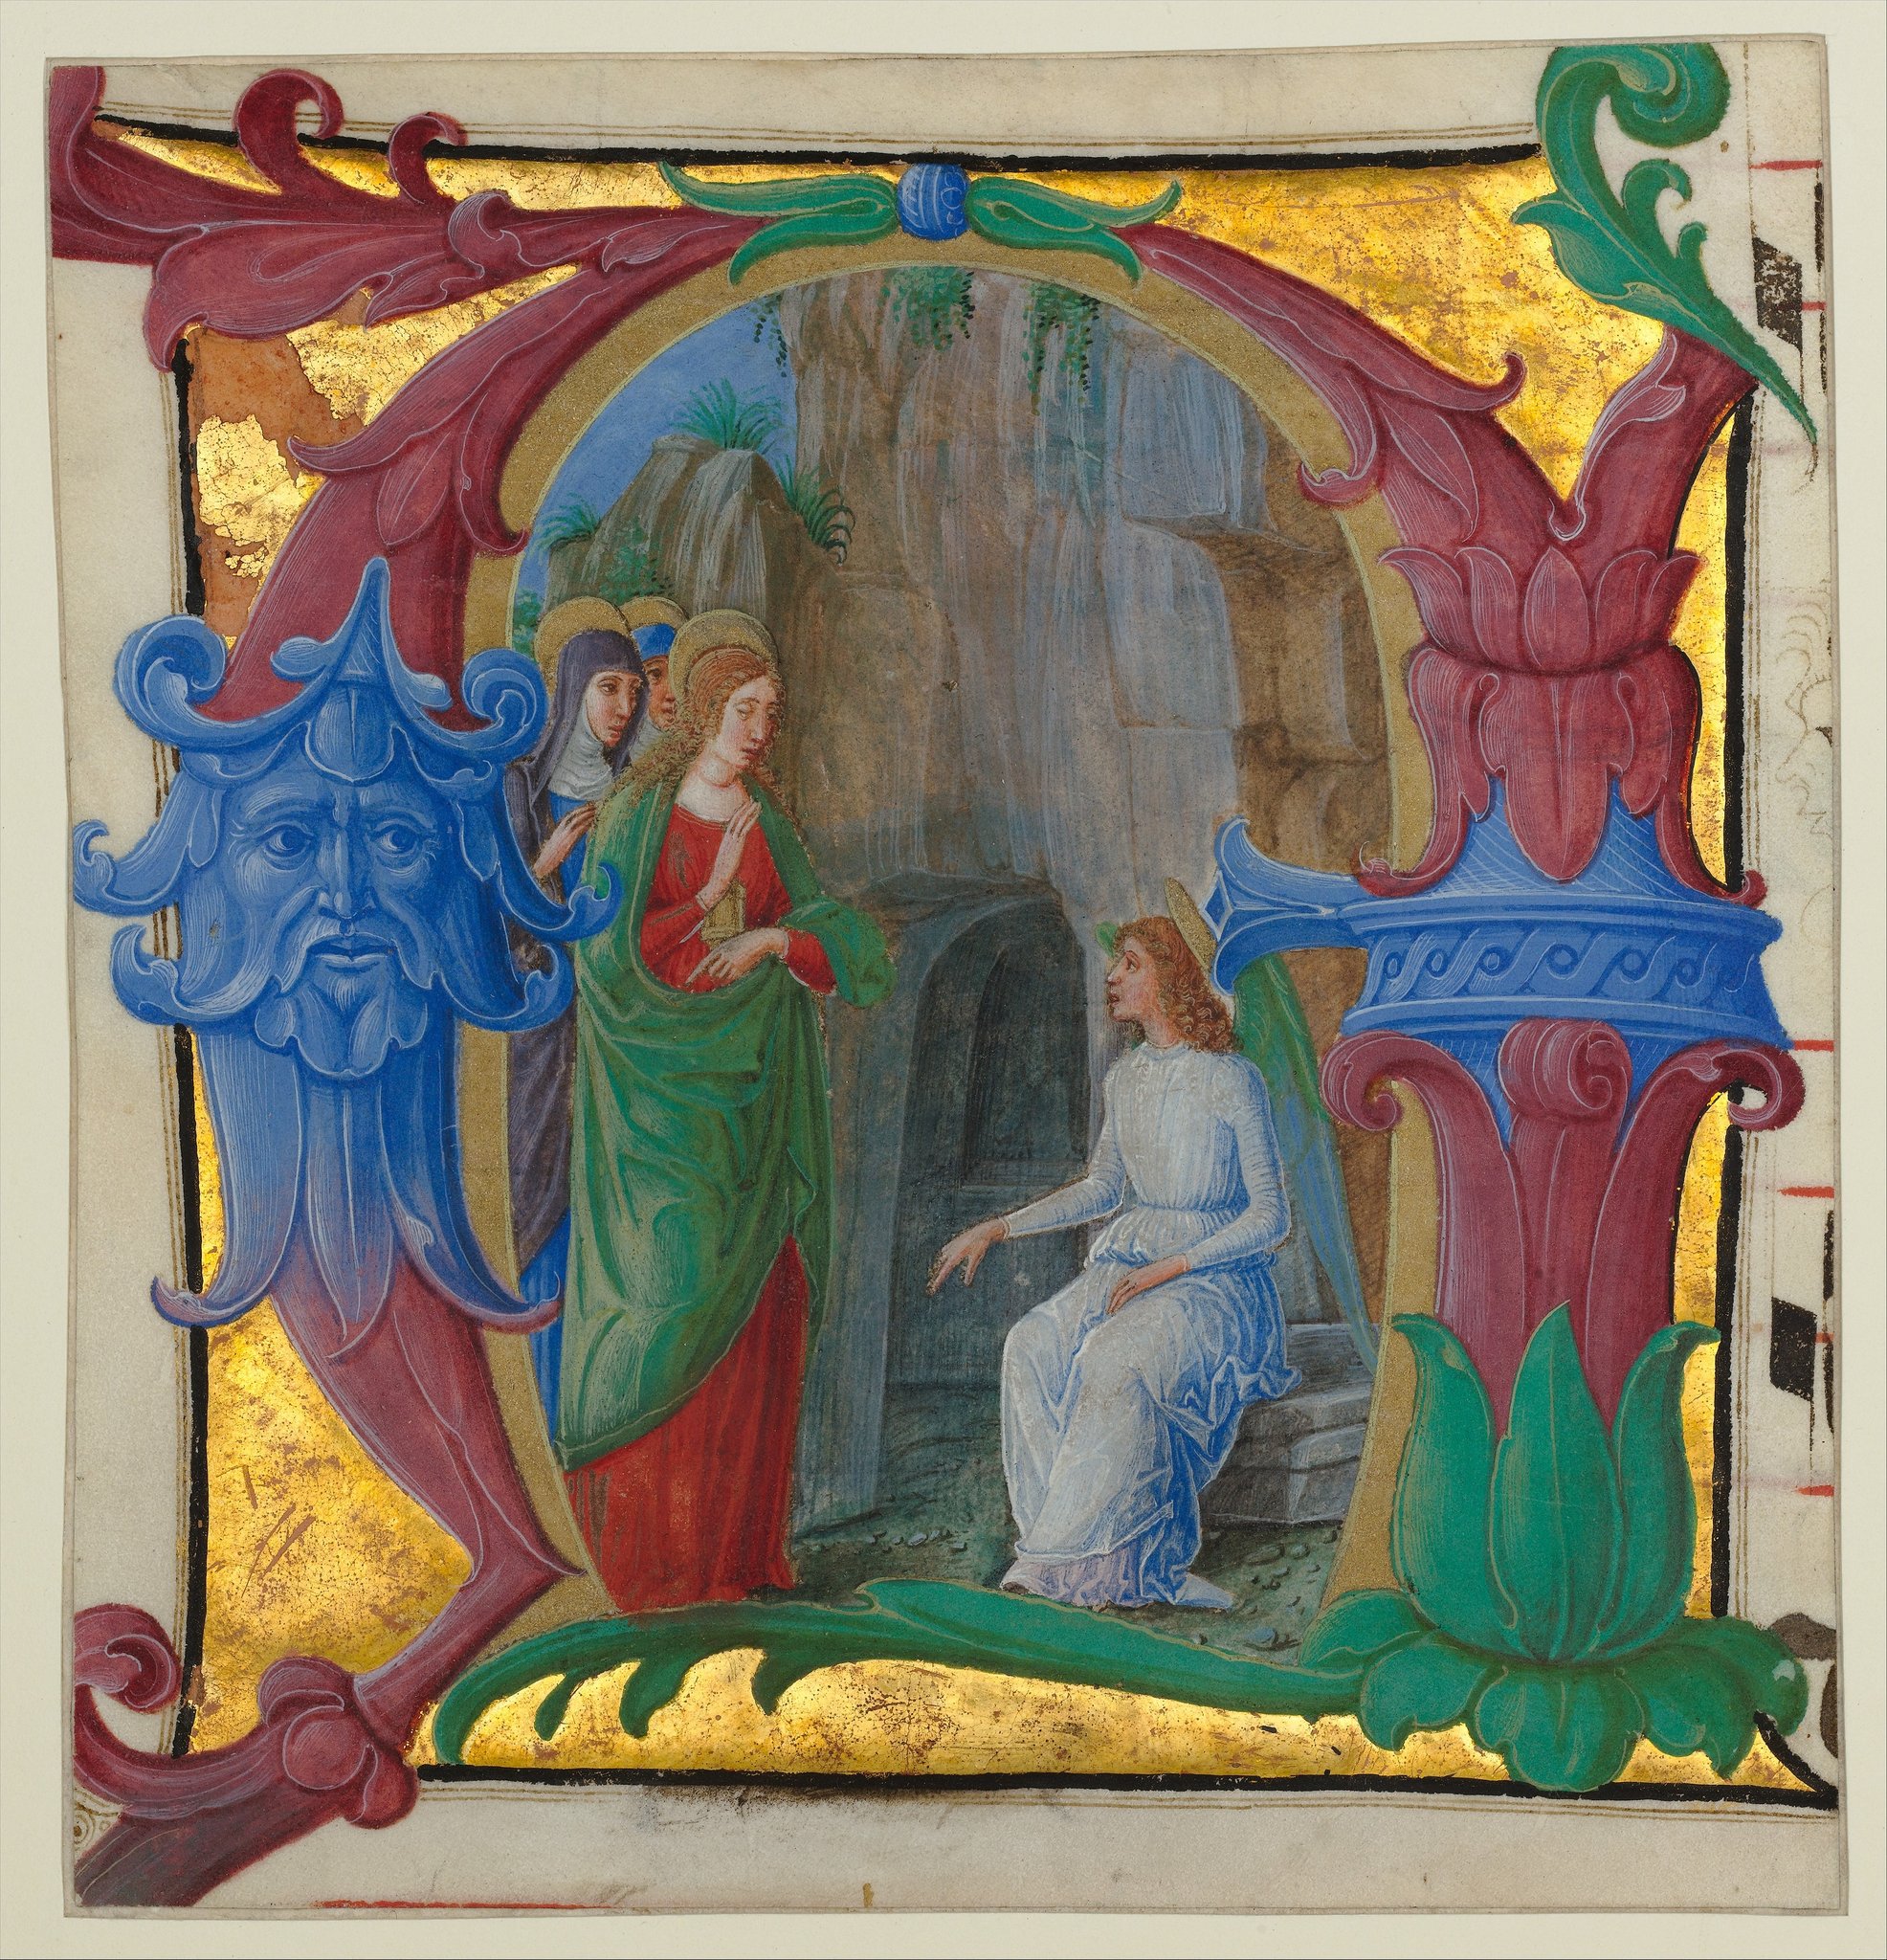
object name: antiphonary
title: Manuscript Illumination with the Holy Women at the Tomb in an Initial A, from an Antiphonary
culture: italian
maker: girolamo dai libri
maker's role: artist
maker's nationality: italian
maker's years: 1474-1555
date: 1490-1500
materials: gold, ink, parchment, paint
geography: italy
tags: tombs,women